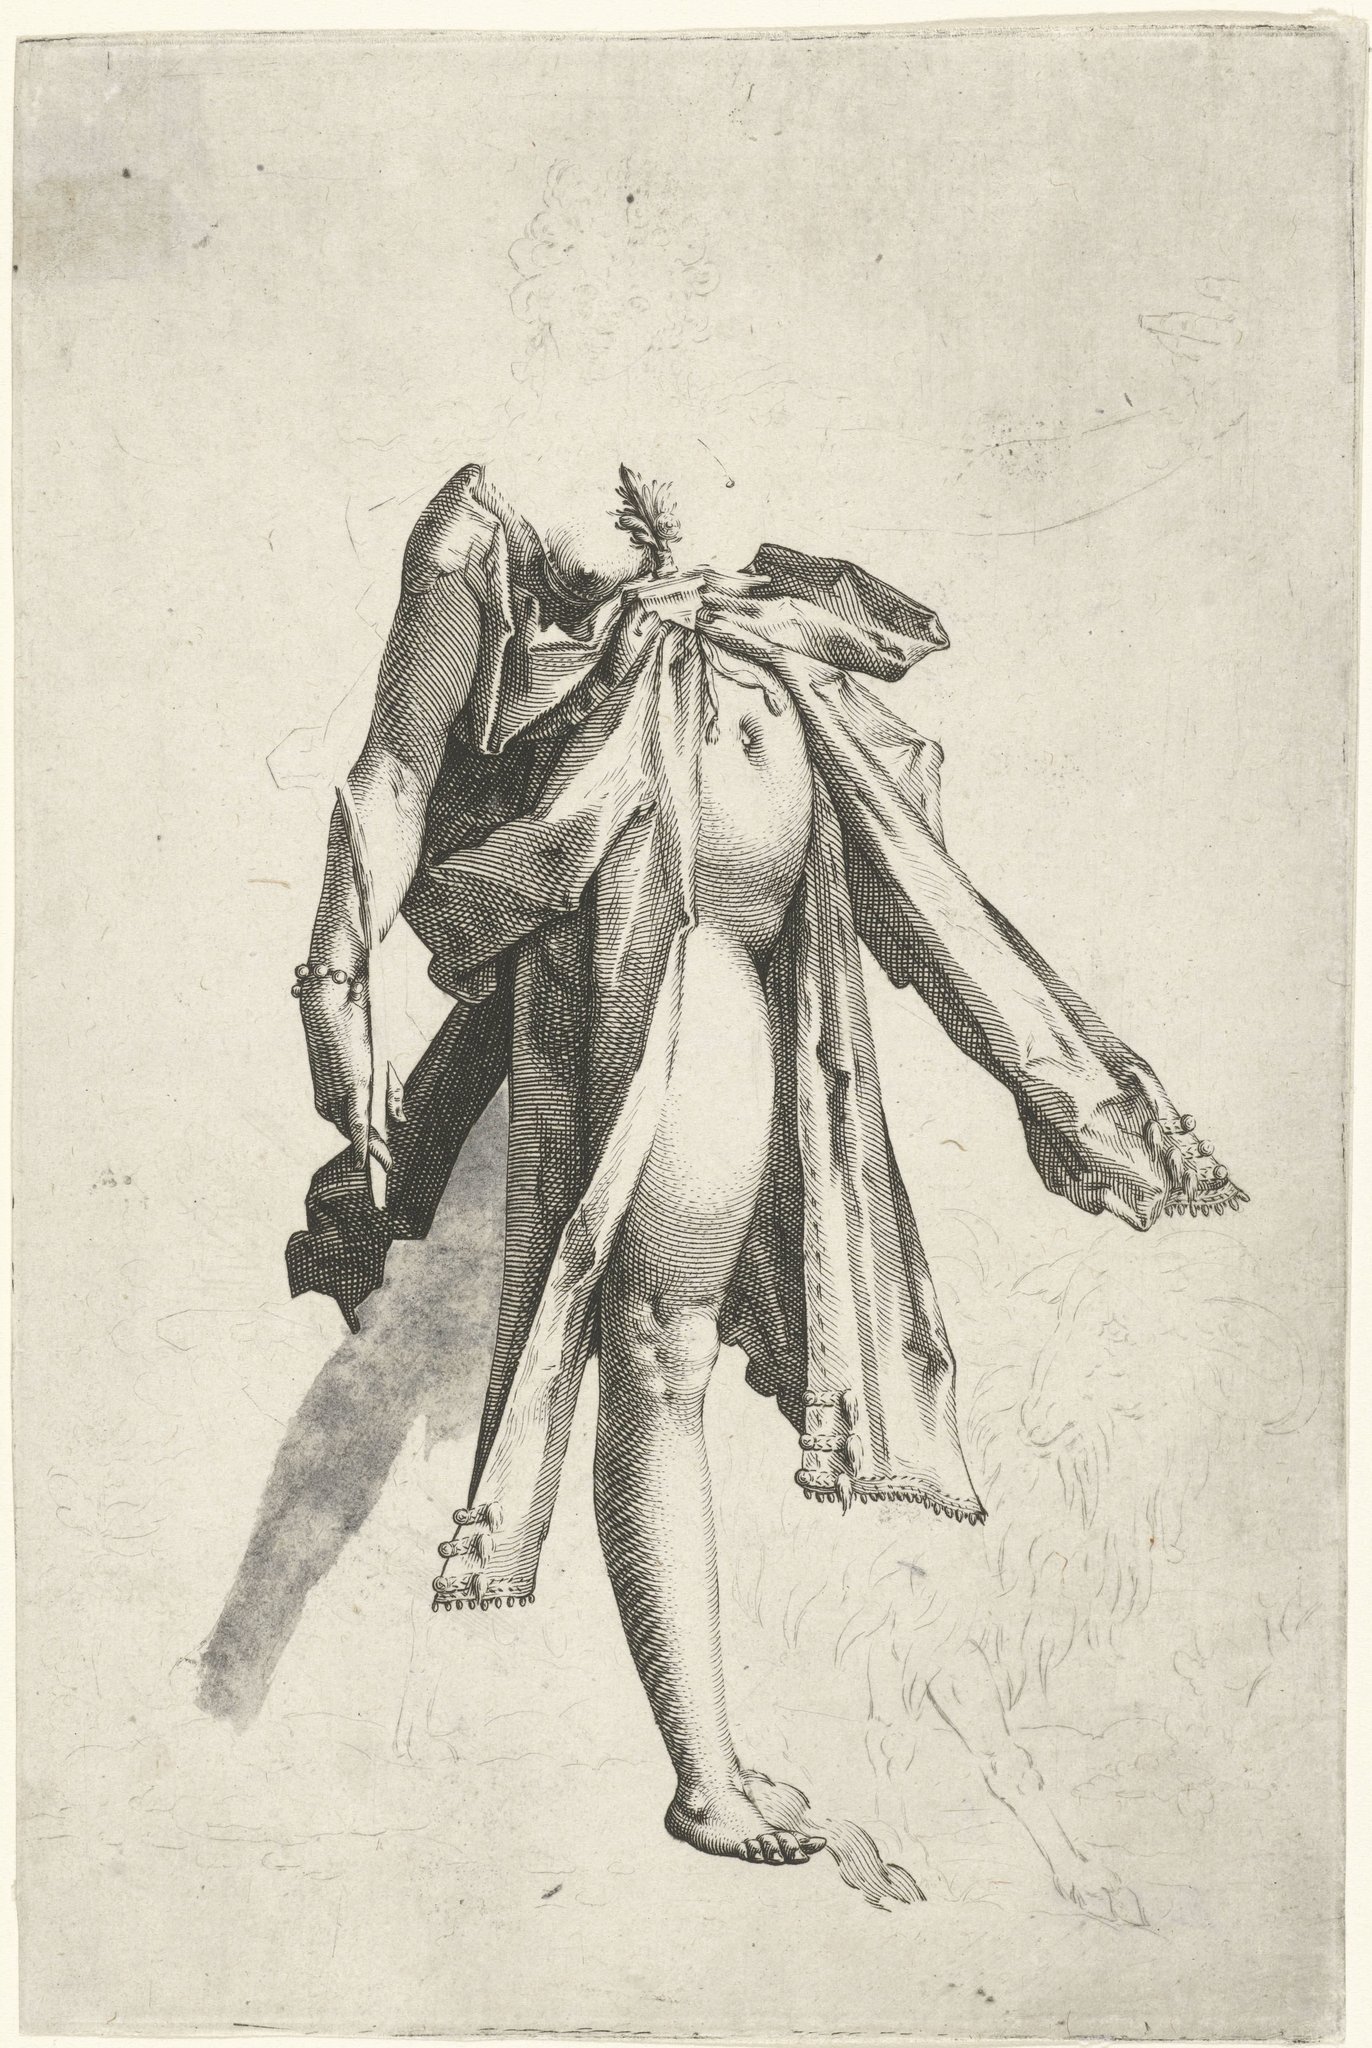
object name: print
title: De zonden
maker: jacob matham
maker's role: draughtsman, print maker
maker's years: 1571-1631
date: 1585-1589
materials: paper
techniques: brush, drypoint, engraving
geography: haarlem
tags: lust, luxury, 'luxuria'; 'lussuria' (ripa) ~ personification of one of the deadly sins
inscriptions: collector's mark: Lugt 240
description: De gepersonifieerde Wellus; een vrouwenfiguur met een vogeltje en een bloemtak in een landschap, naast haar een geit.